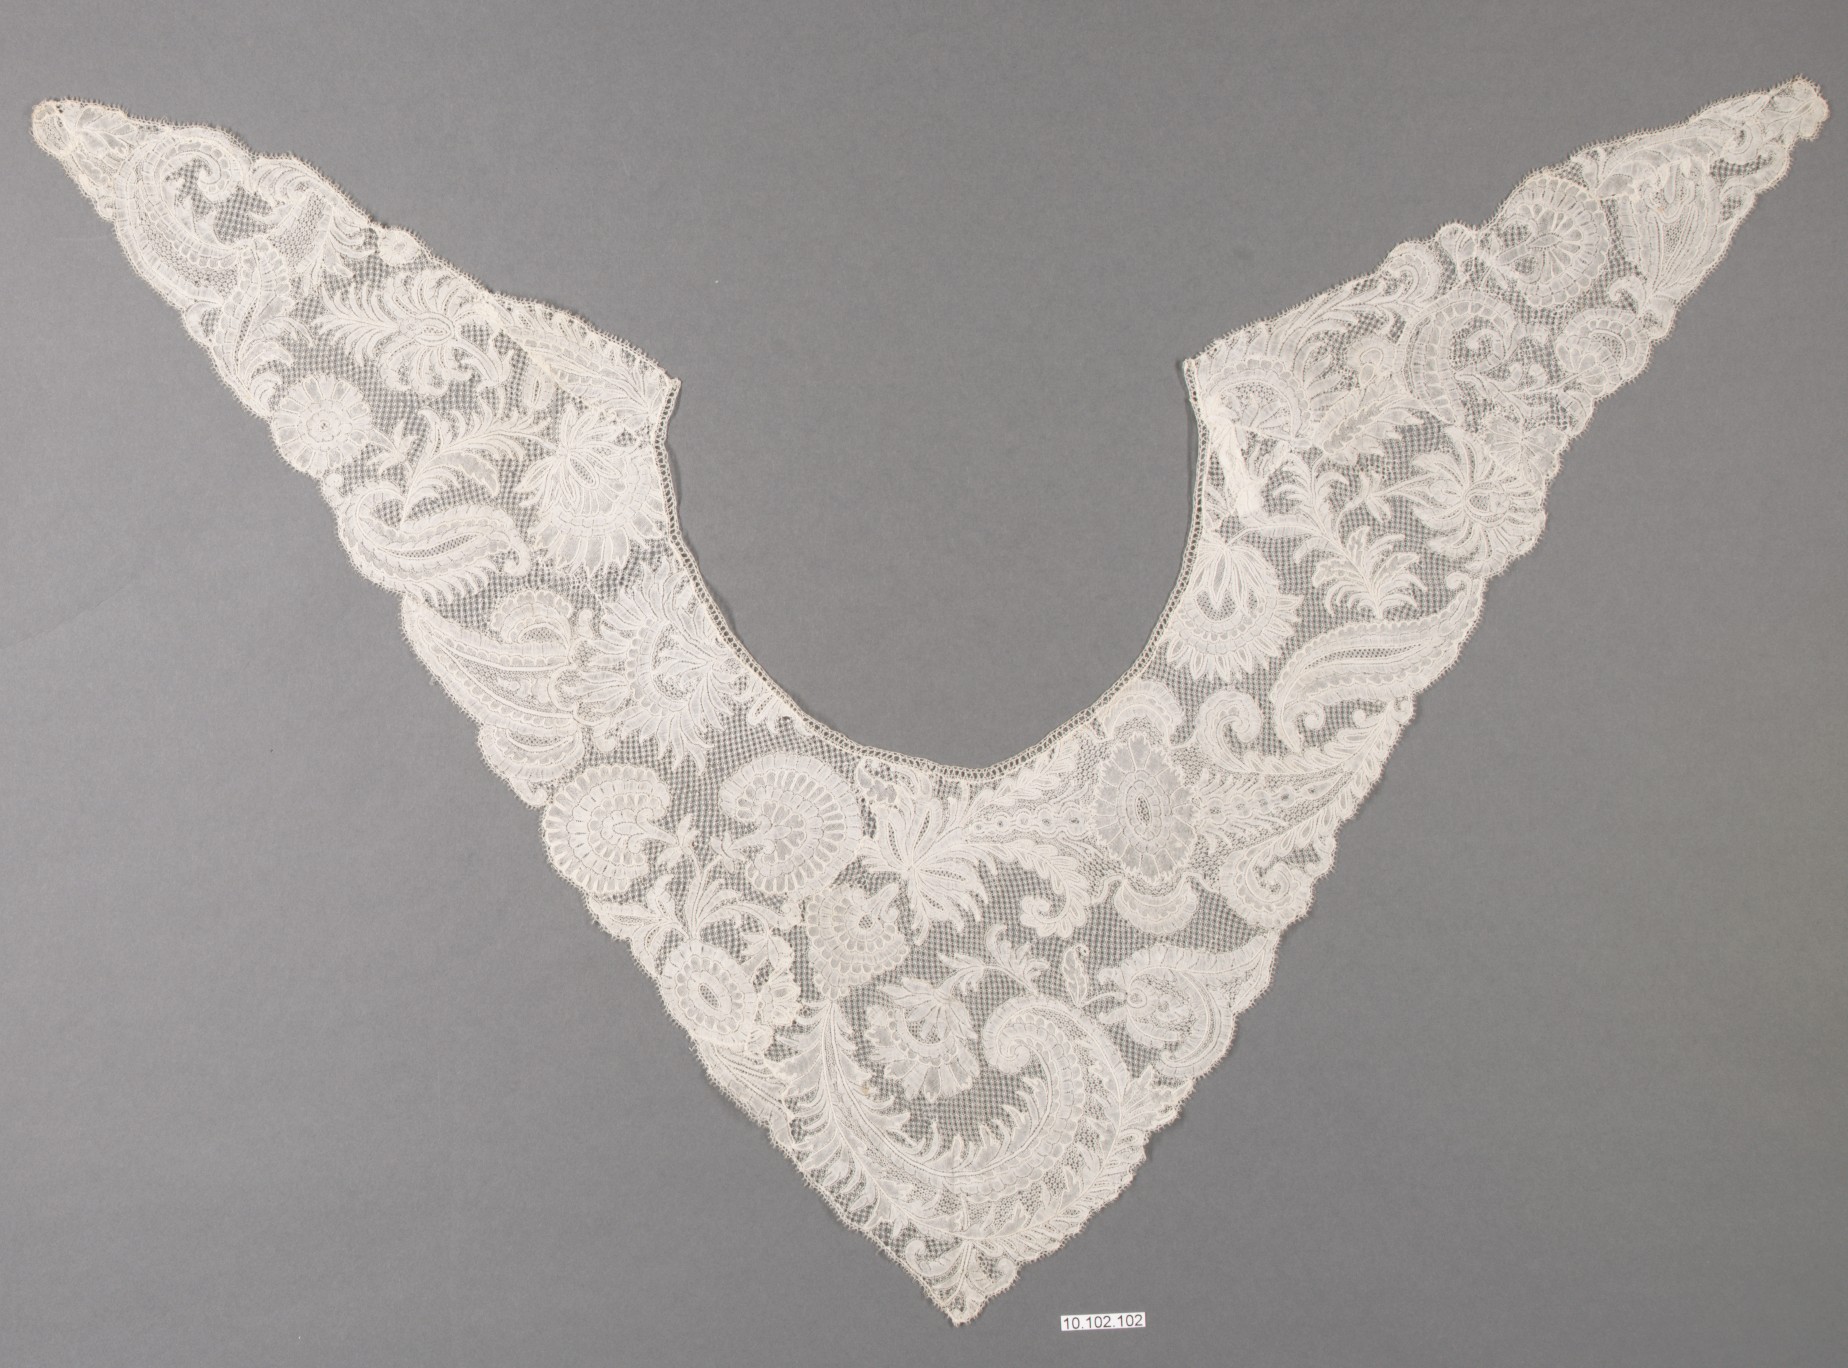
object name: collarette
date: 1701-1800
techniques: lace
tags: flowers